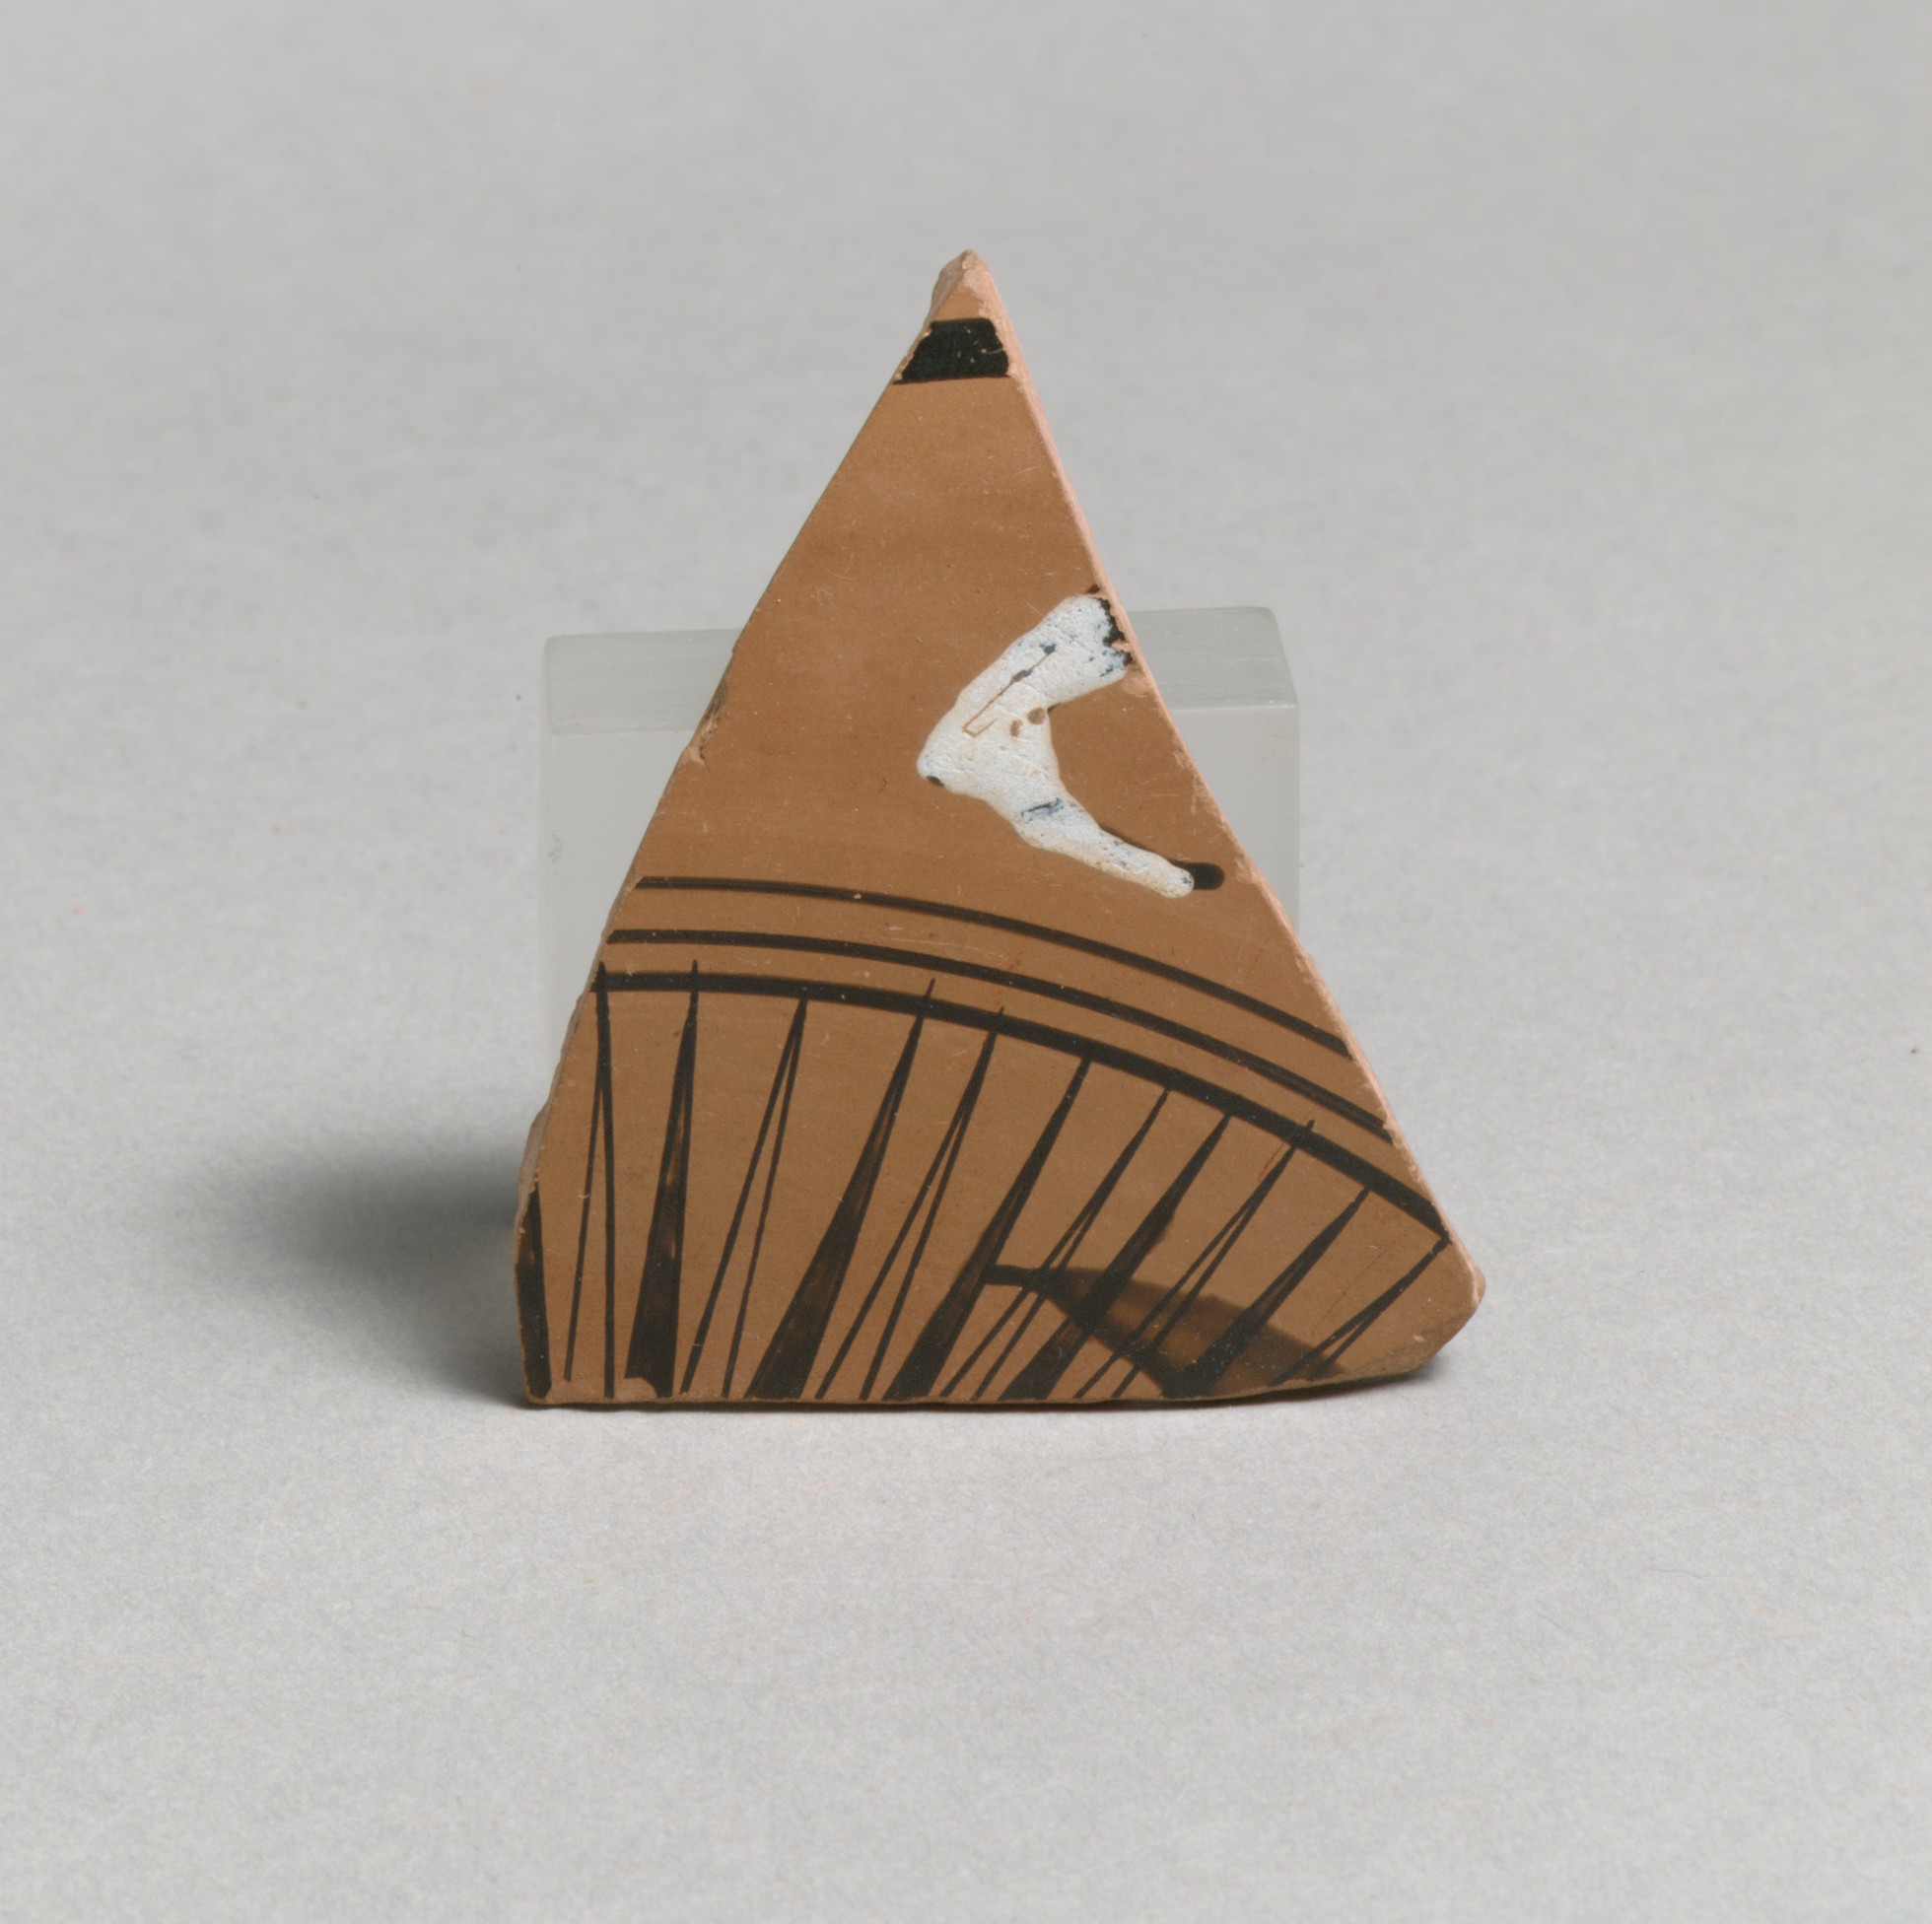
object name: kylix, eye cup fragment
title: Kylix, eye-cup fragment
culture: greek, attic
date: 550-526 BCE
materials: terracotta